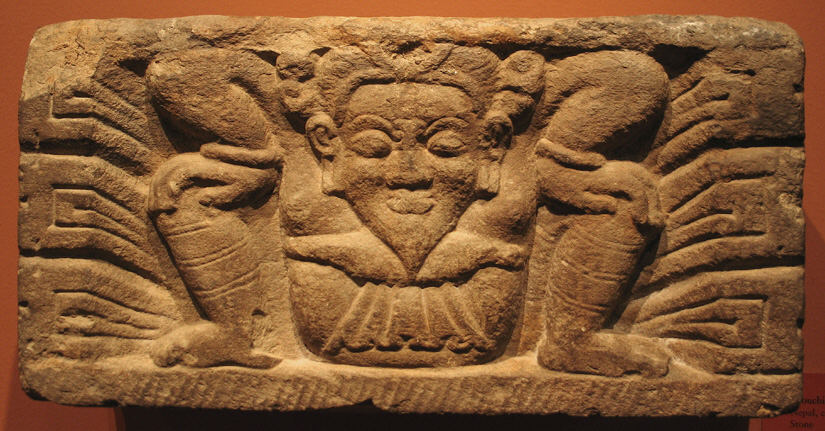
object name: panel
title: Yaksha Relief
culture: nepali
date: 701-900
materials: stone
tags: buddhism,deities